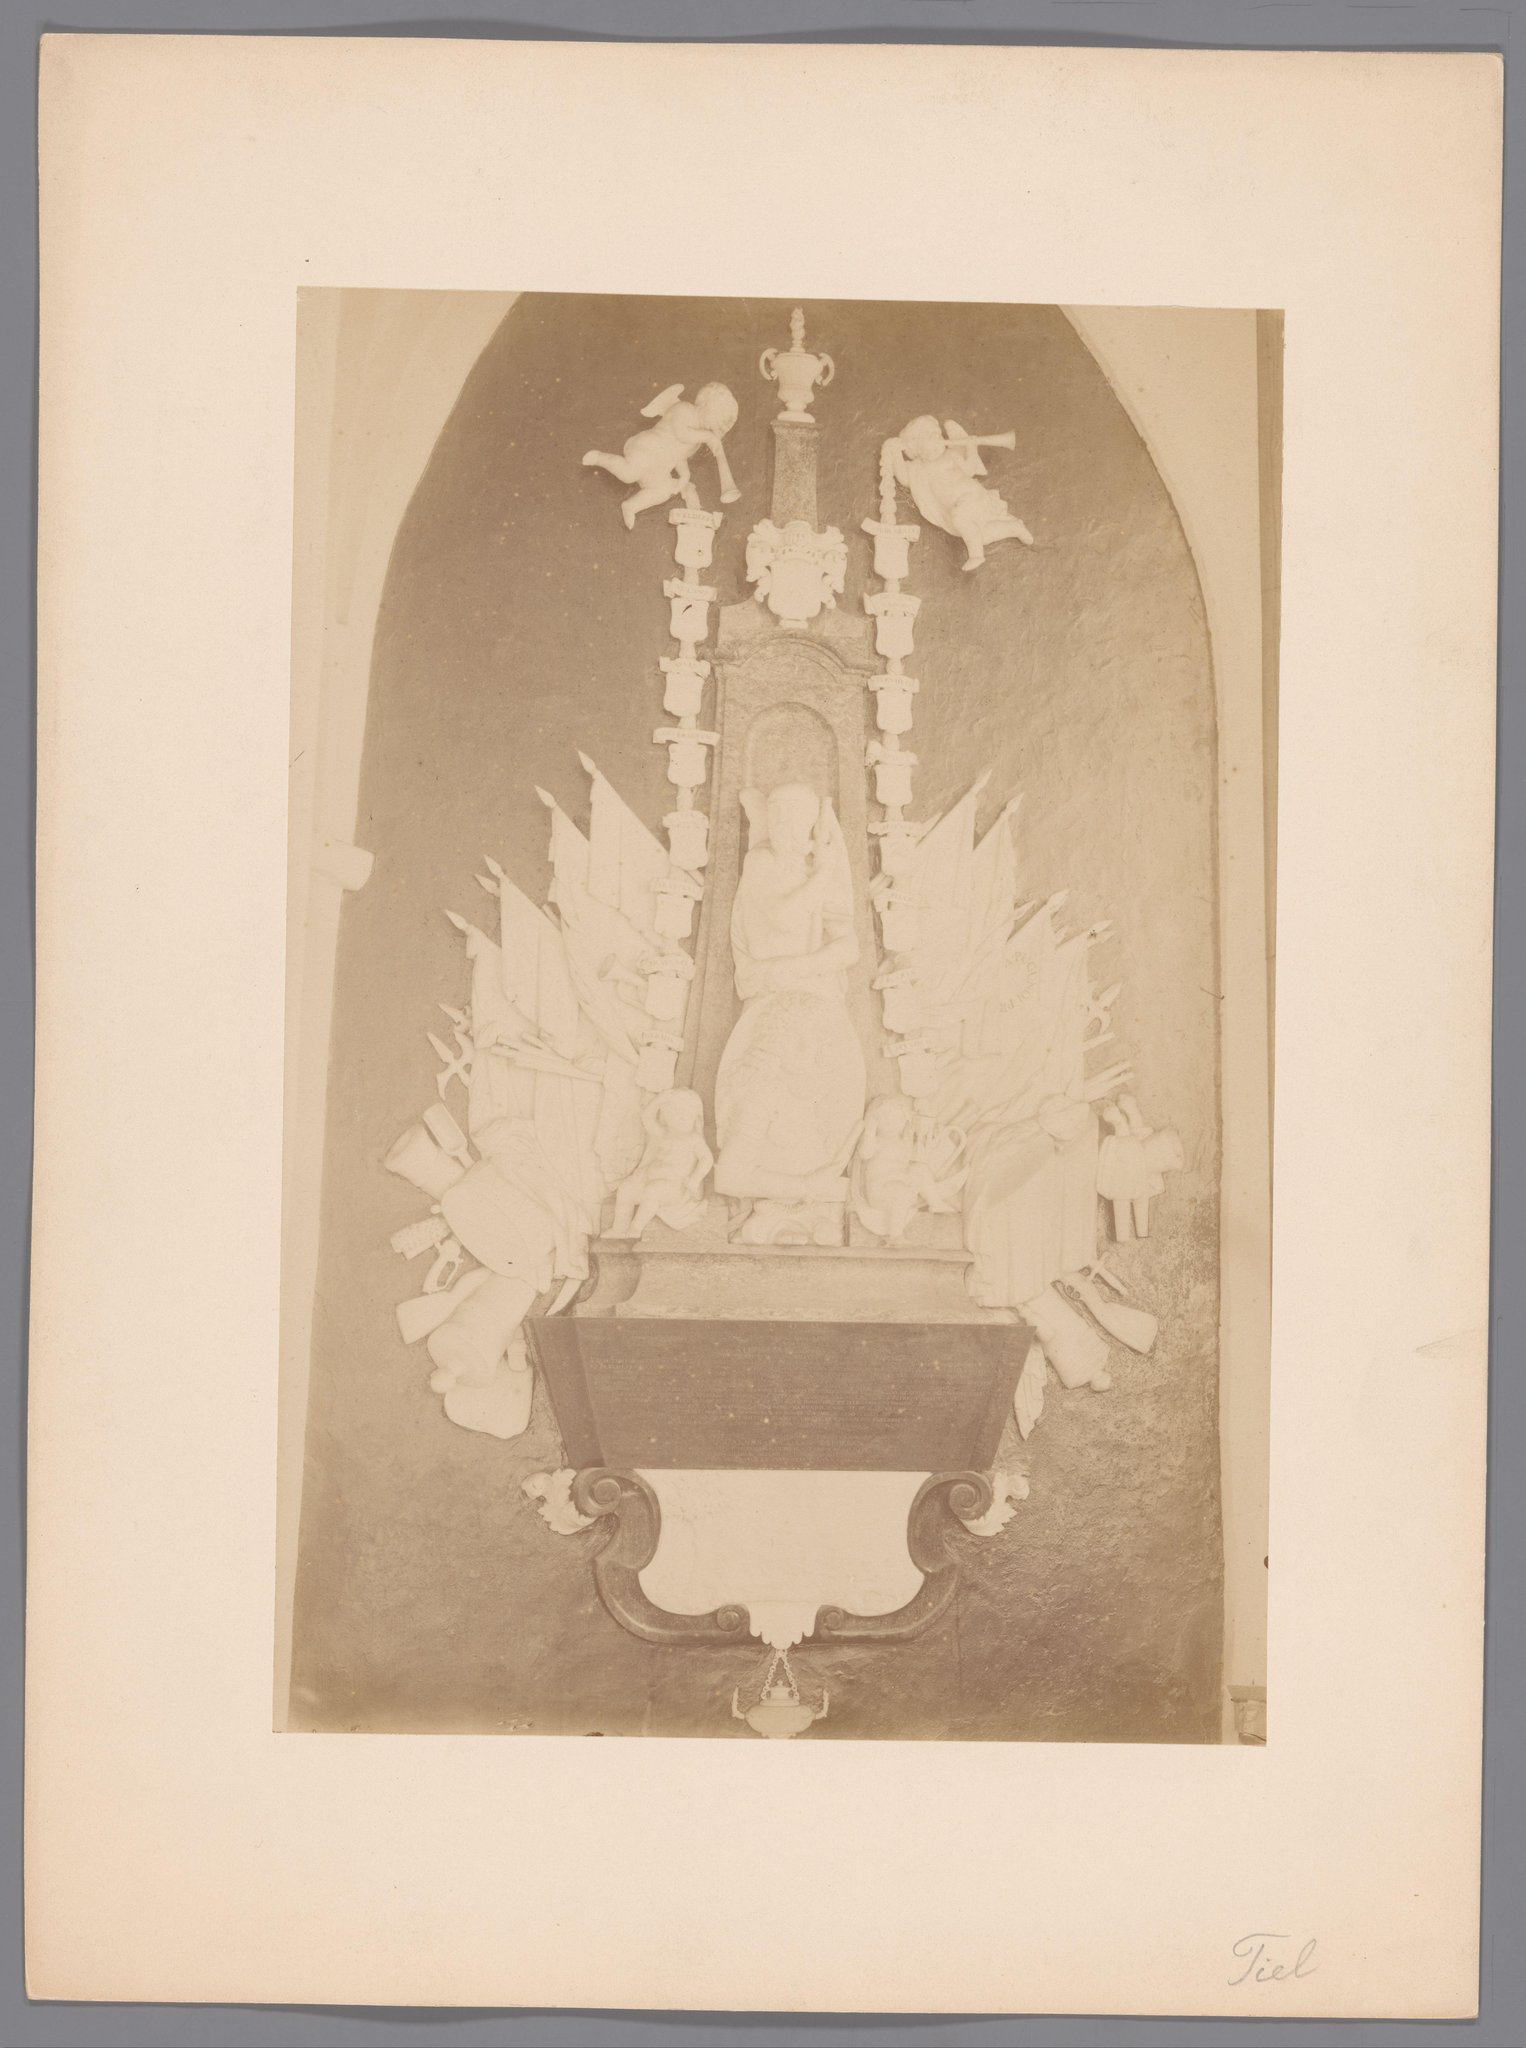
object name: photograph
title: Grafmonument van Steven van Welderen in de Grote of Sint-Maartenskerk te Tiel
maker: anoniem (monumentenzorg)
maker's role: fotograaf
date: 1893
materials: cardboard, photographic support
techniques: albumen print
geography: tiel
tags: grave-building, monumental tomb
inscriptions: annotation: ‘Tiel/ Praalgraf van den Brigadier/ Steven van Welderen/ in de groote of st. Maartenskerk/ Maart 1893’, annotation: ‘Tiel’